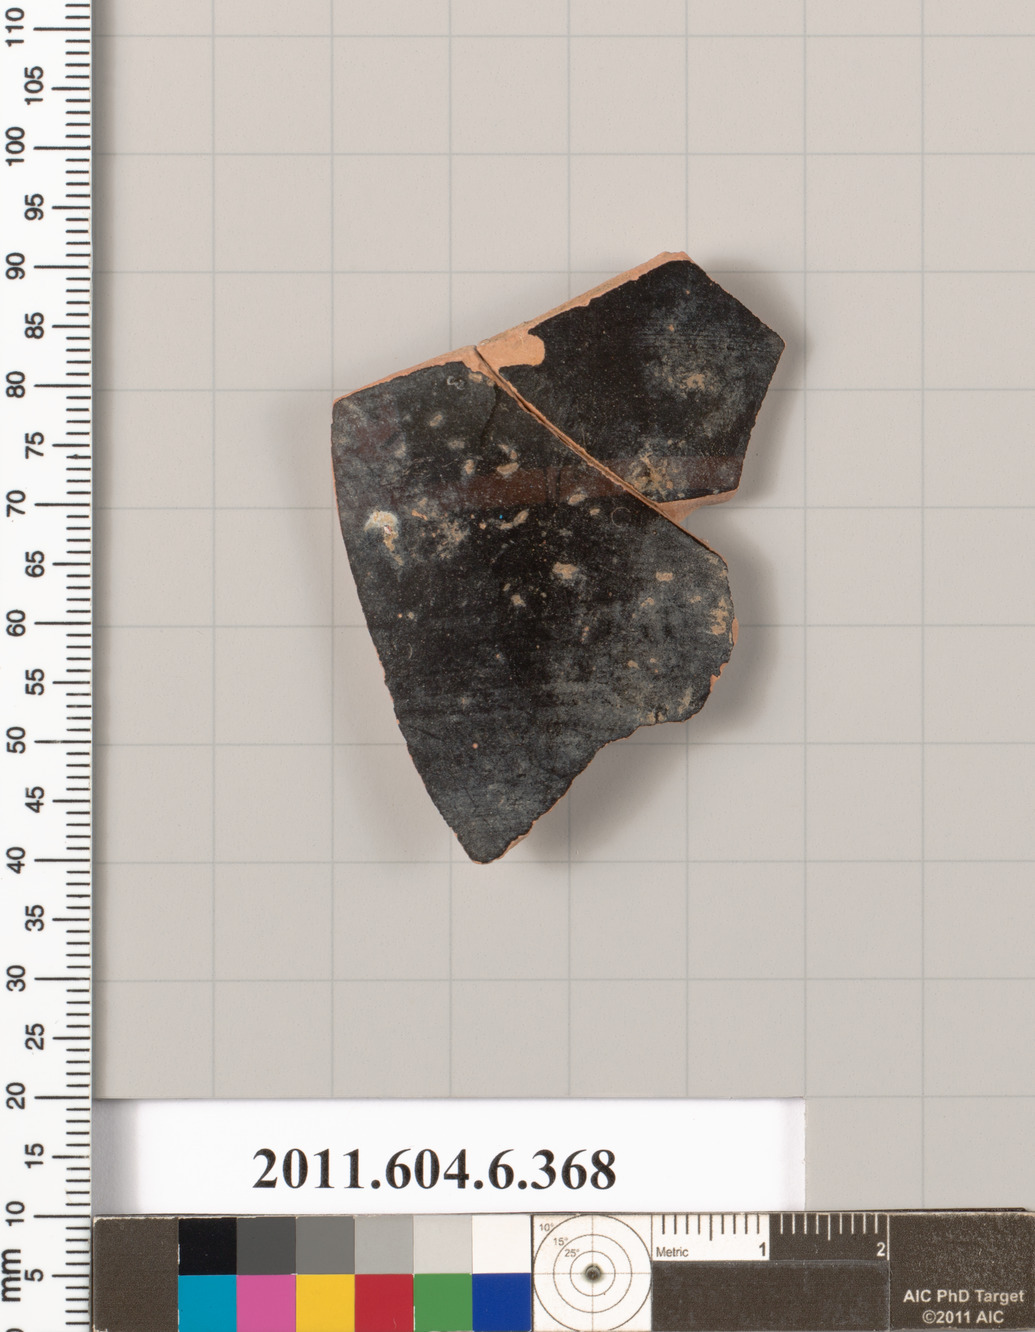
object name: undetermined closed shape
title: Terracotta fragment of a closed shape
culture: greek, attic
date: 600-401 BCE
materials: terracotta